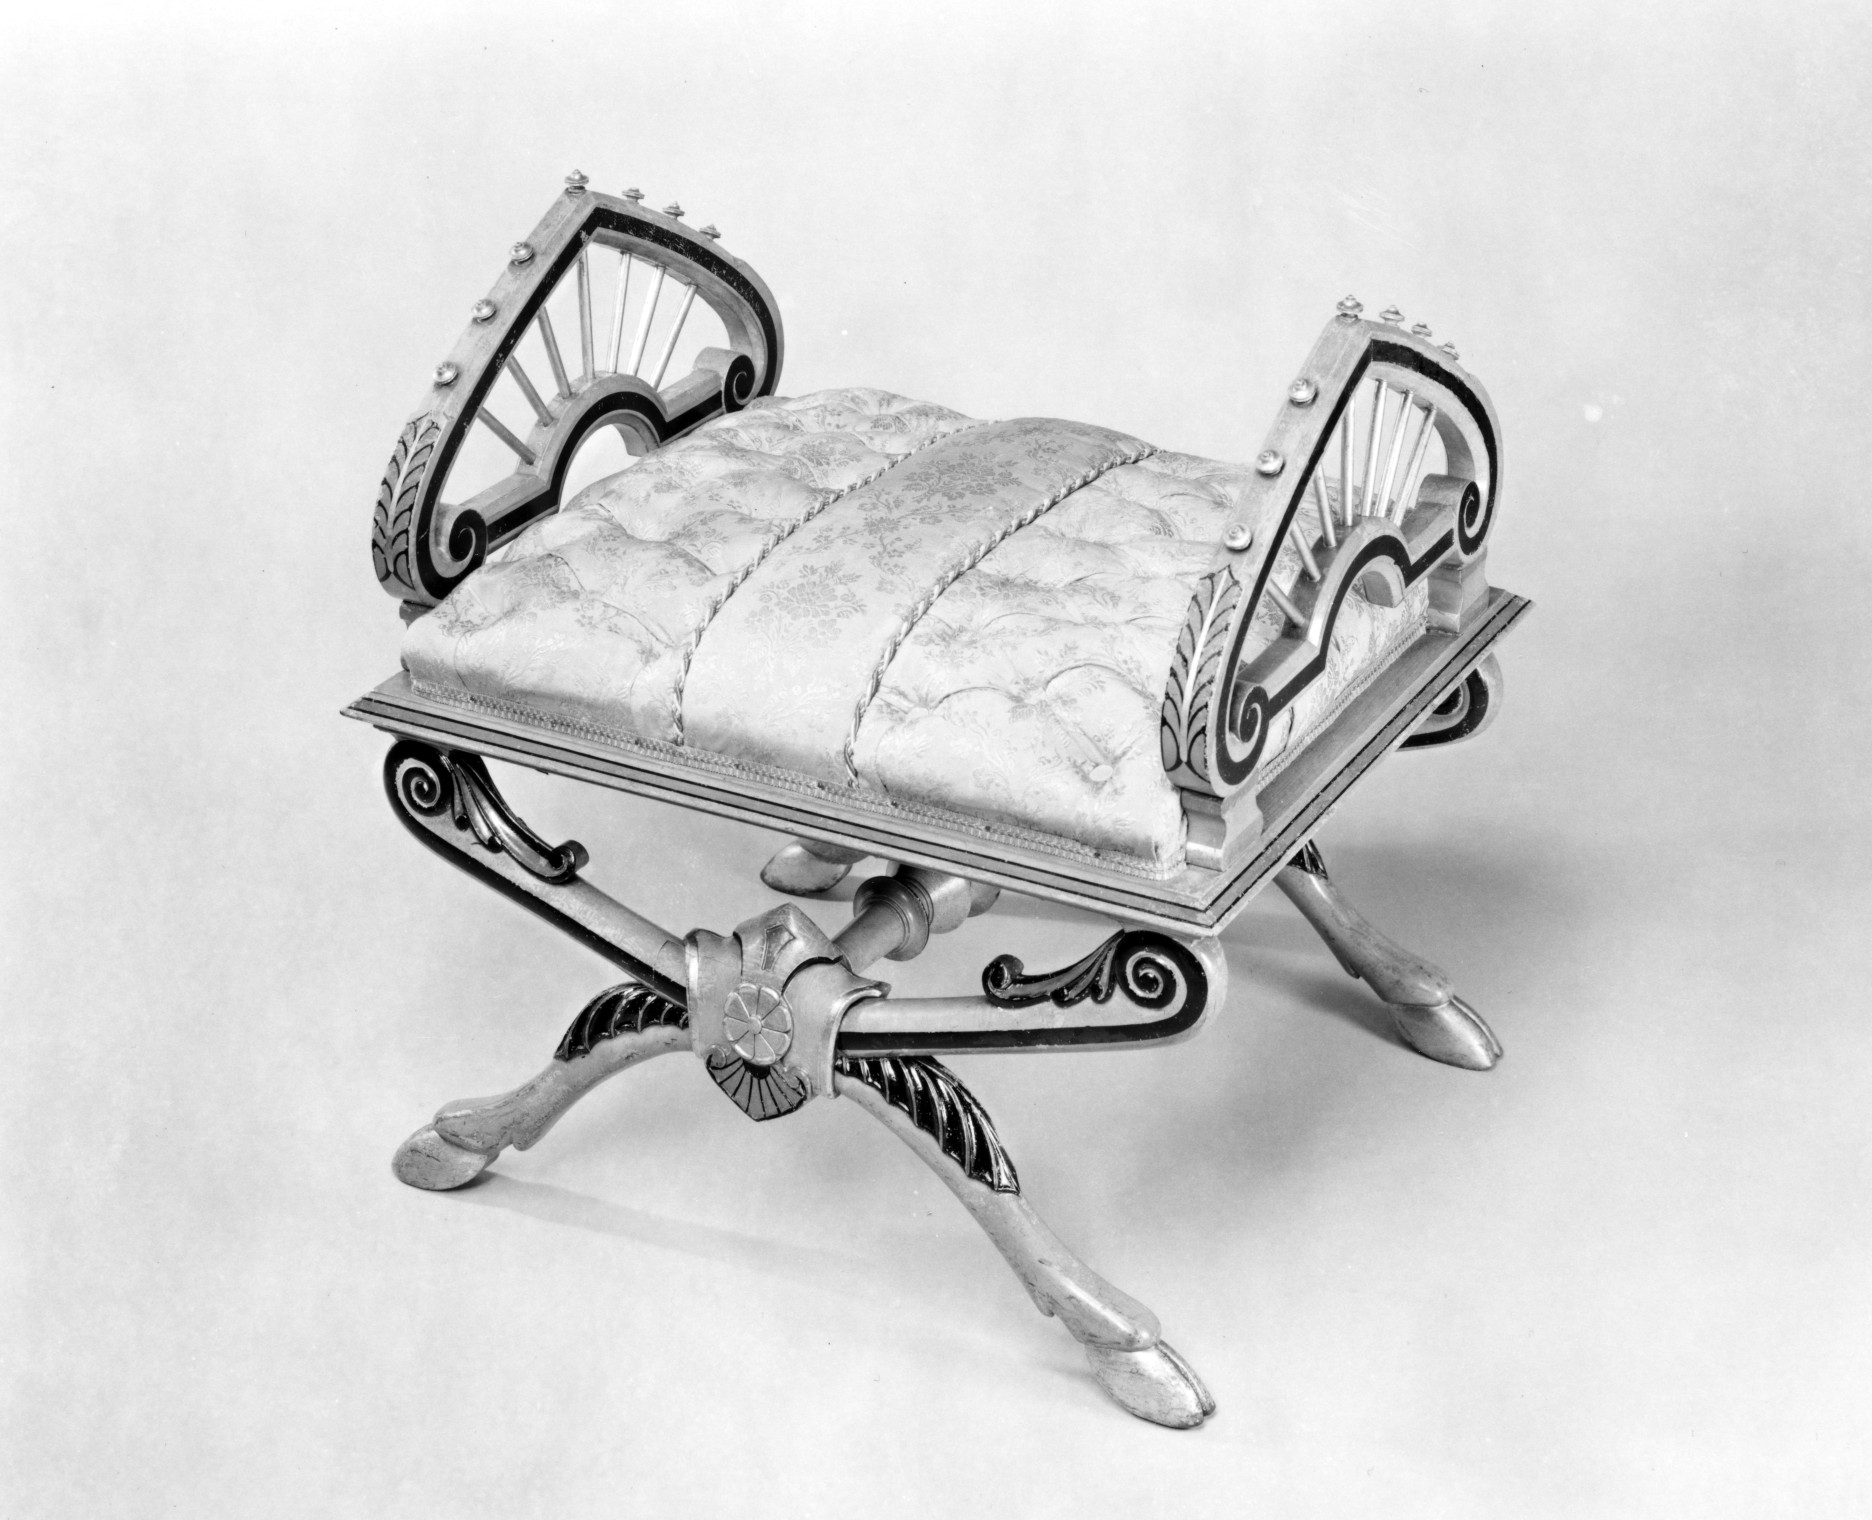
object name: bench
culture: american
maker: alexander roux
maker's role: maker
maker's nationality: french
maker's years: 1813-1886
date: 1865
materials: wood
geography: united states